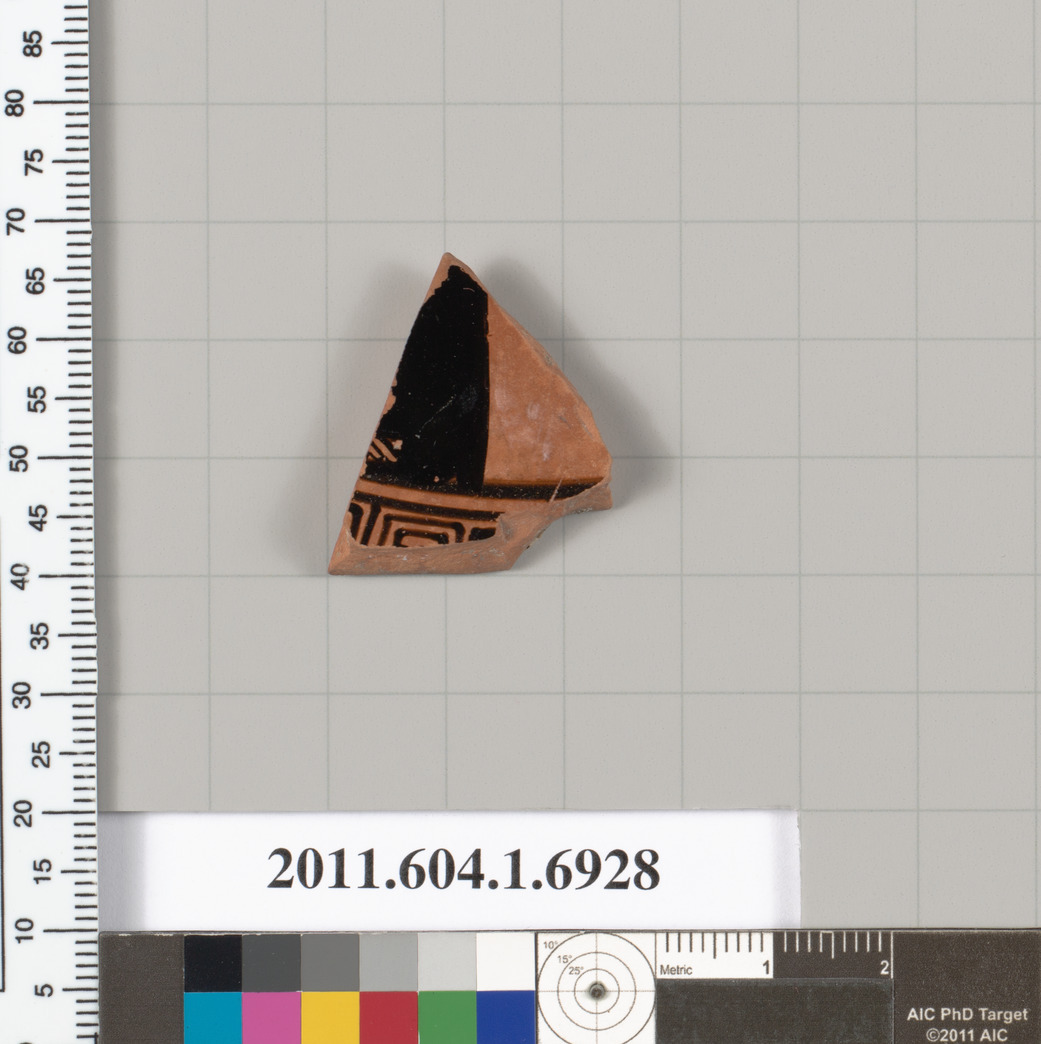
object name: kylix fragment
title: Terracotta fragment of a kylix (drinking cup)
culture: greek, attic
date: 490-470 BCE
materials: terracotta